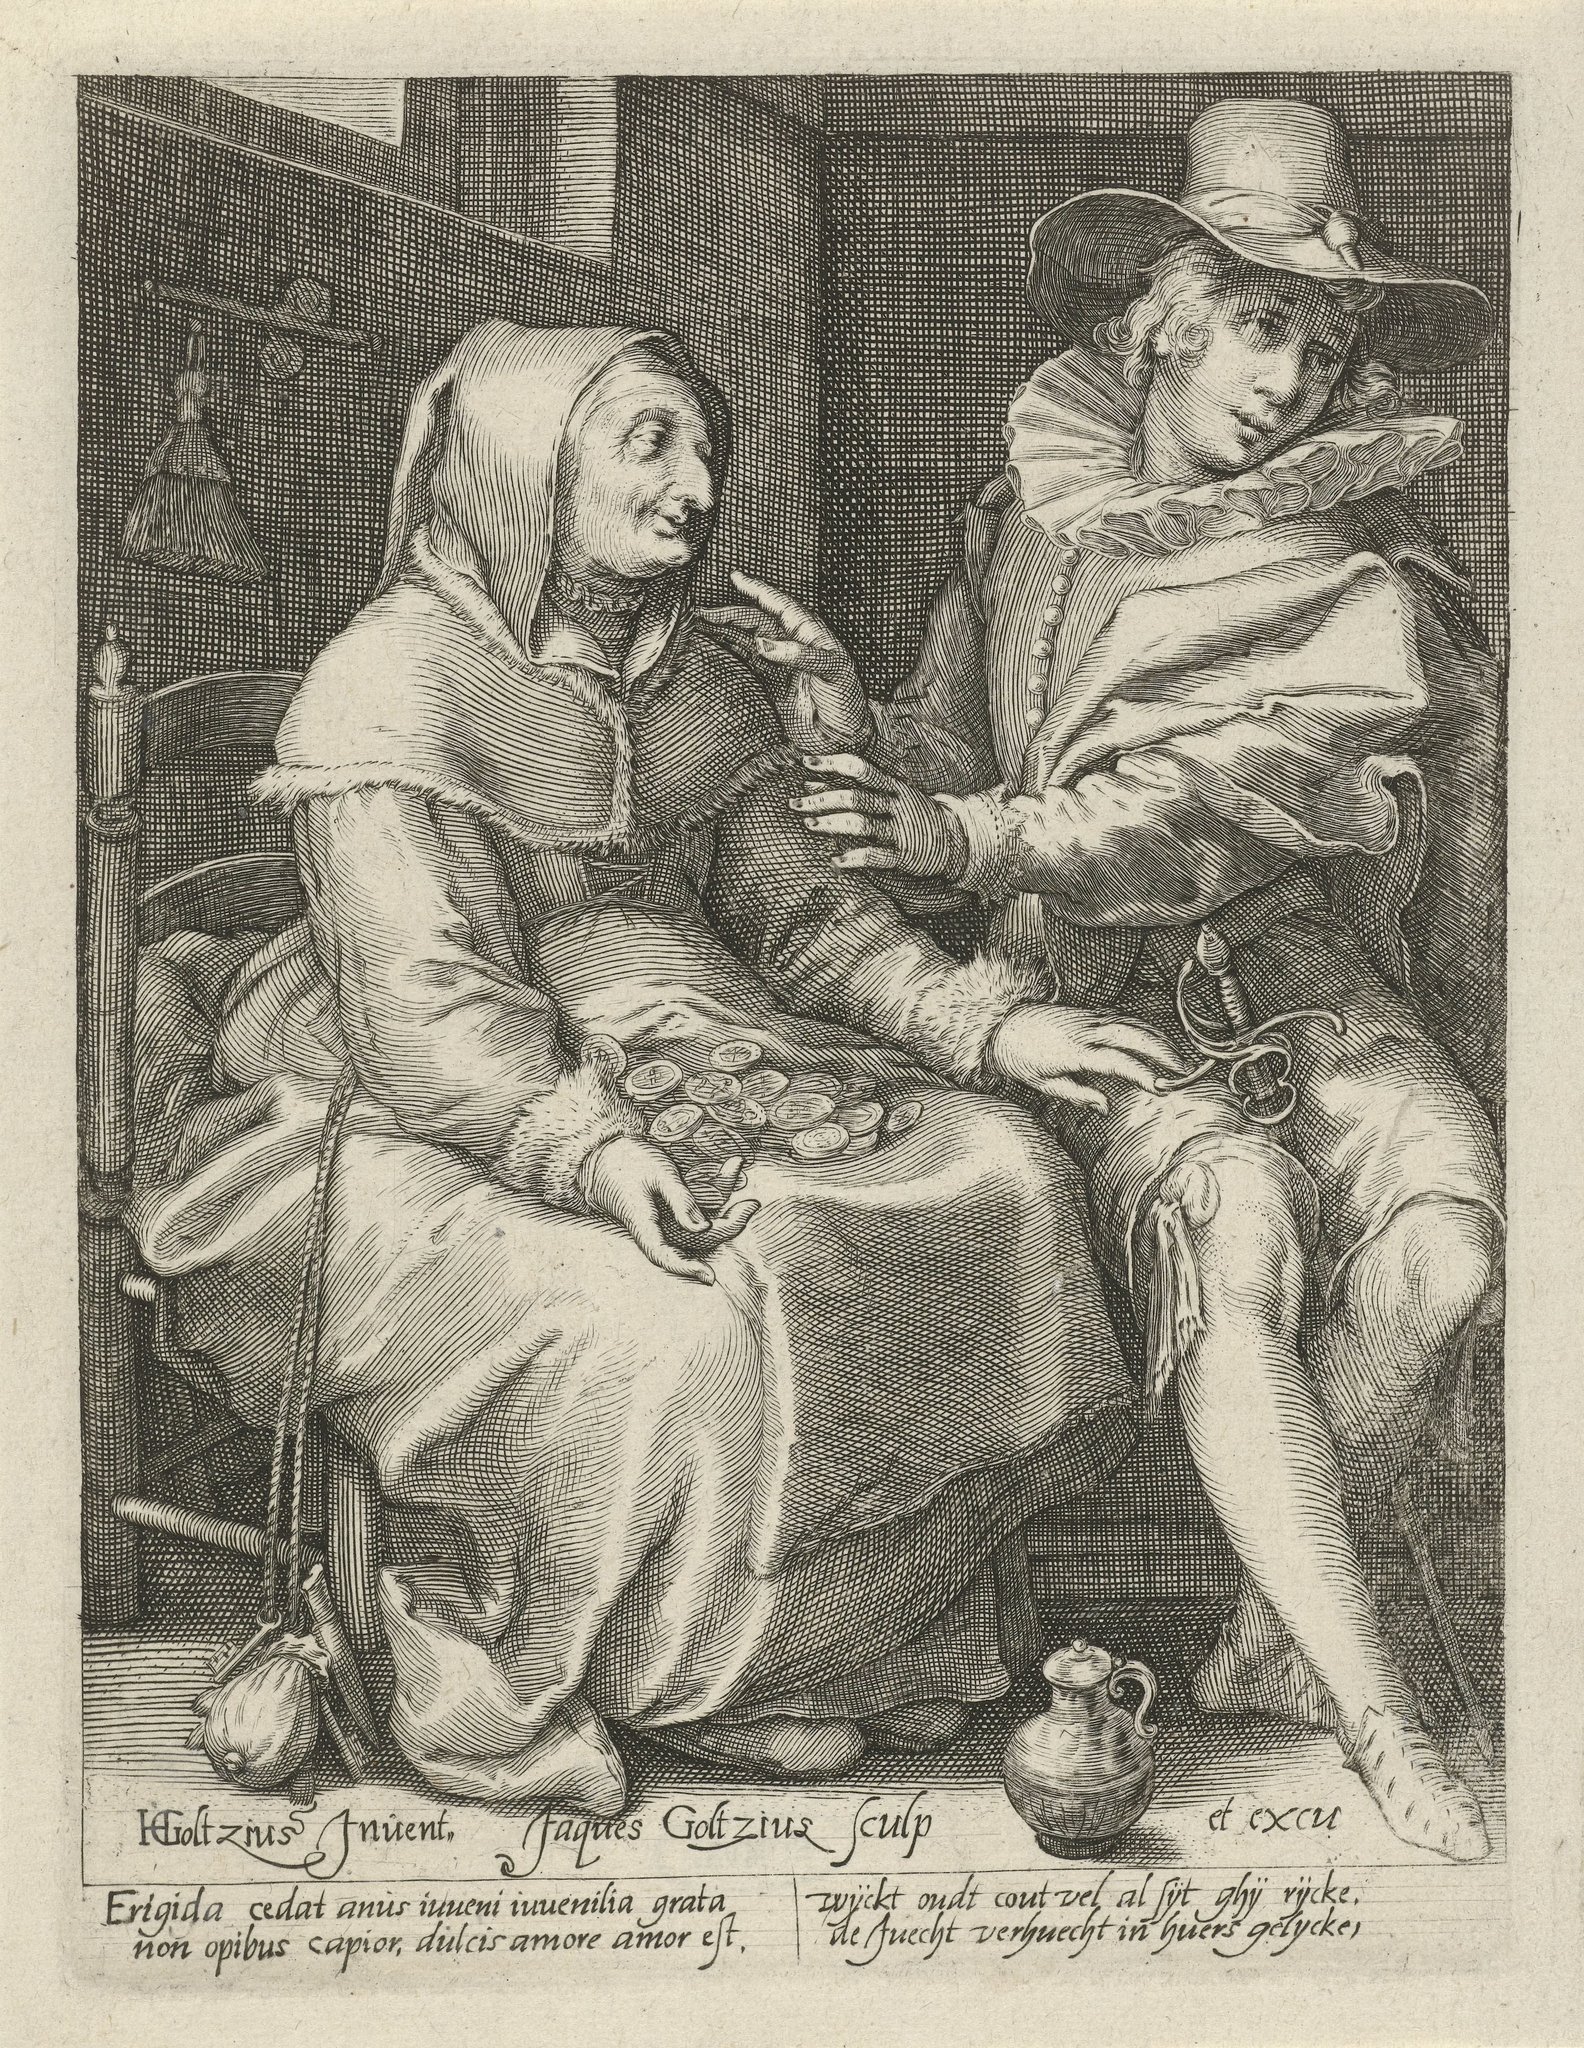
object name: print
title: Ongelijke liefde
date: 1584-1630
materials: paper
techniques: engraving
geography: haarlem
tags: pursuit of a woman, prowling, young versus old age; young and old, ugly old woman, hag, money, married couple of unequal age - dd - woman older, youth, adolescent (+ old male (human being))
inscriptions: collector's mark: Lugt 2228, collector's mark: Lugt 138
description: Een oude vrouw zit op een stoel. In haar schoot een aantal munten. Naast haar een jongeman op een stoel. De vrouw legt haar hand op het been van de man, maar hij draait zich weg van haar. De prent heeft een Latijns en Nederlands onderschrift